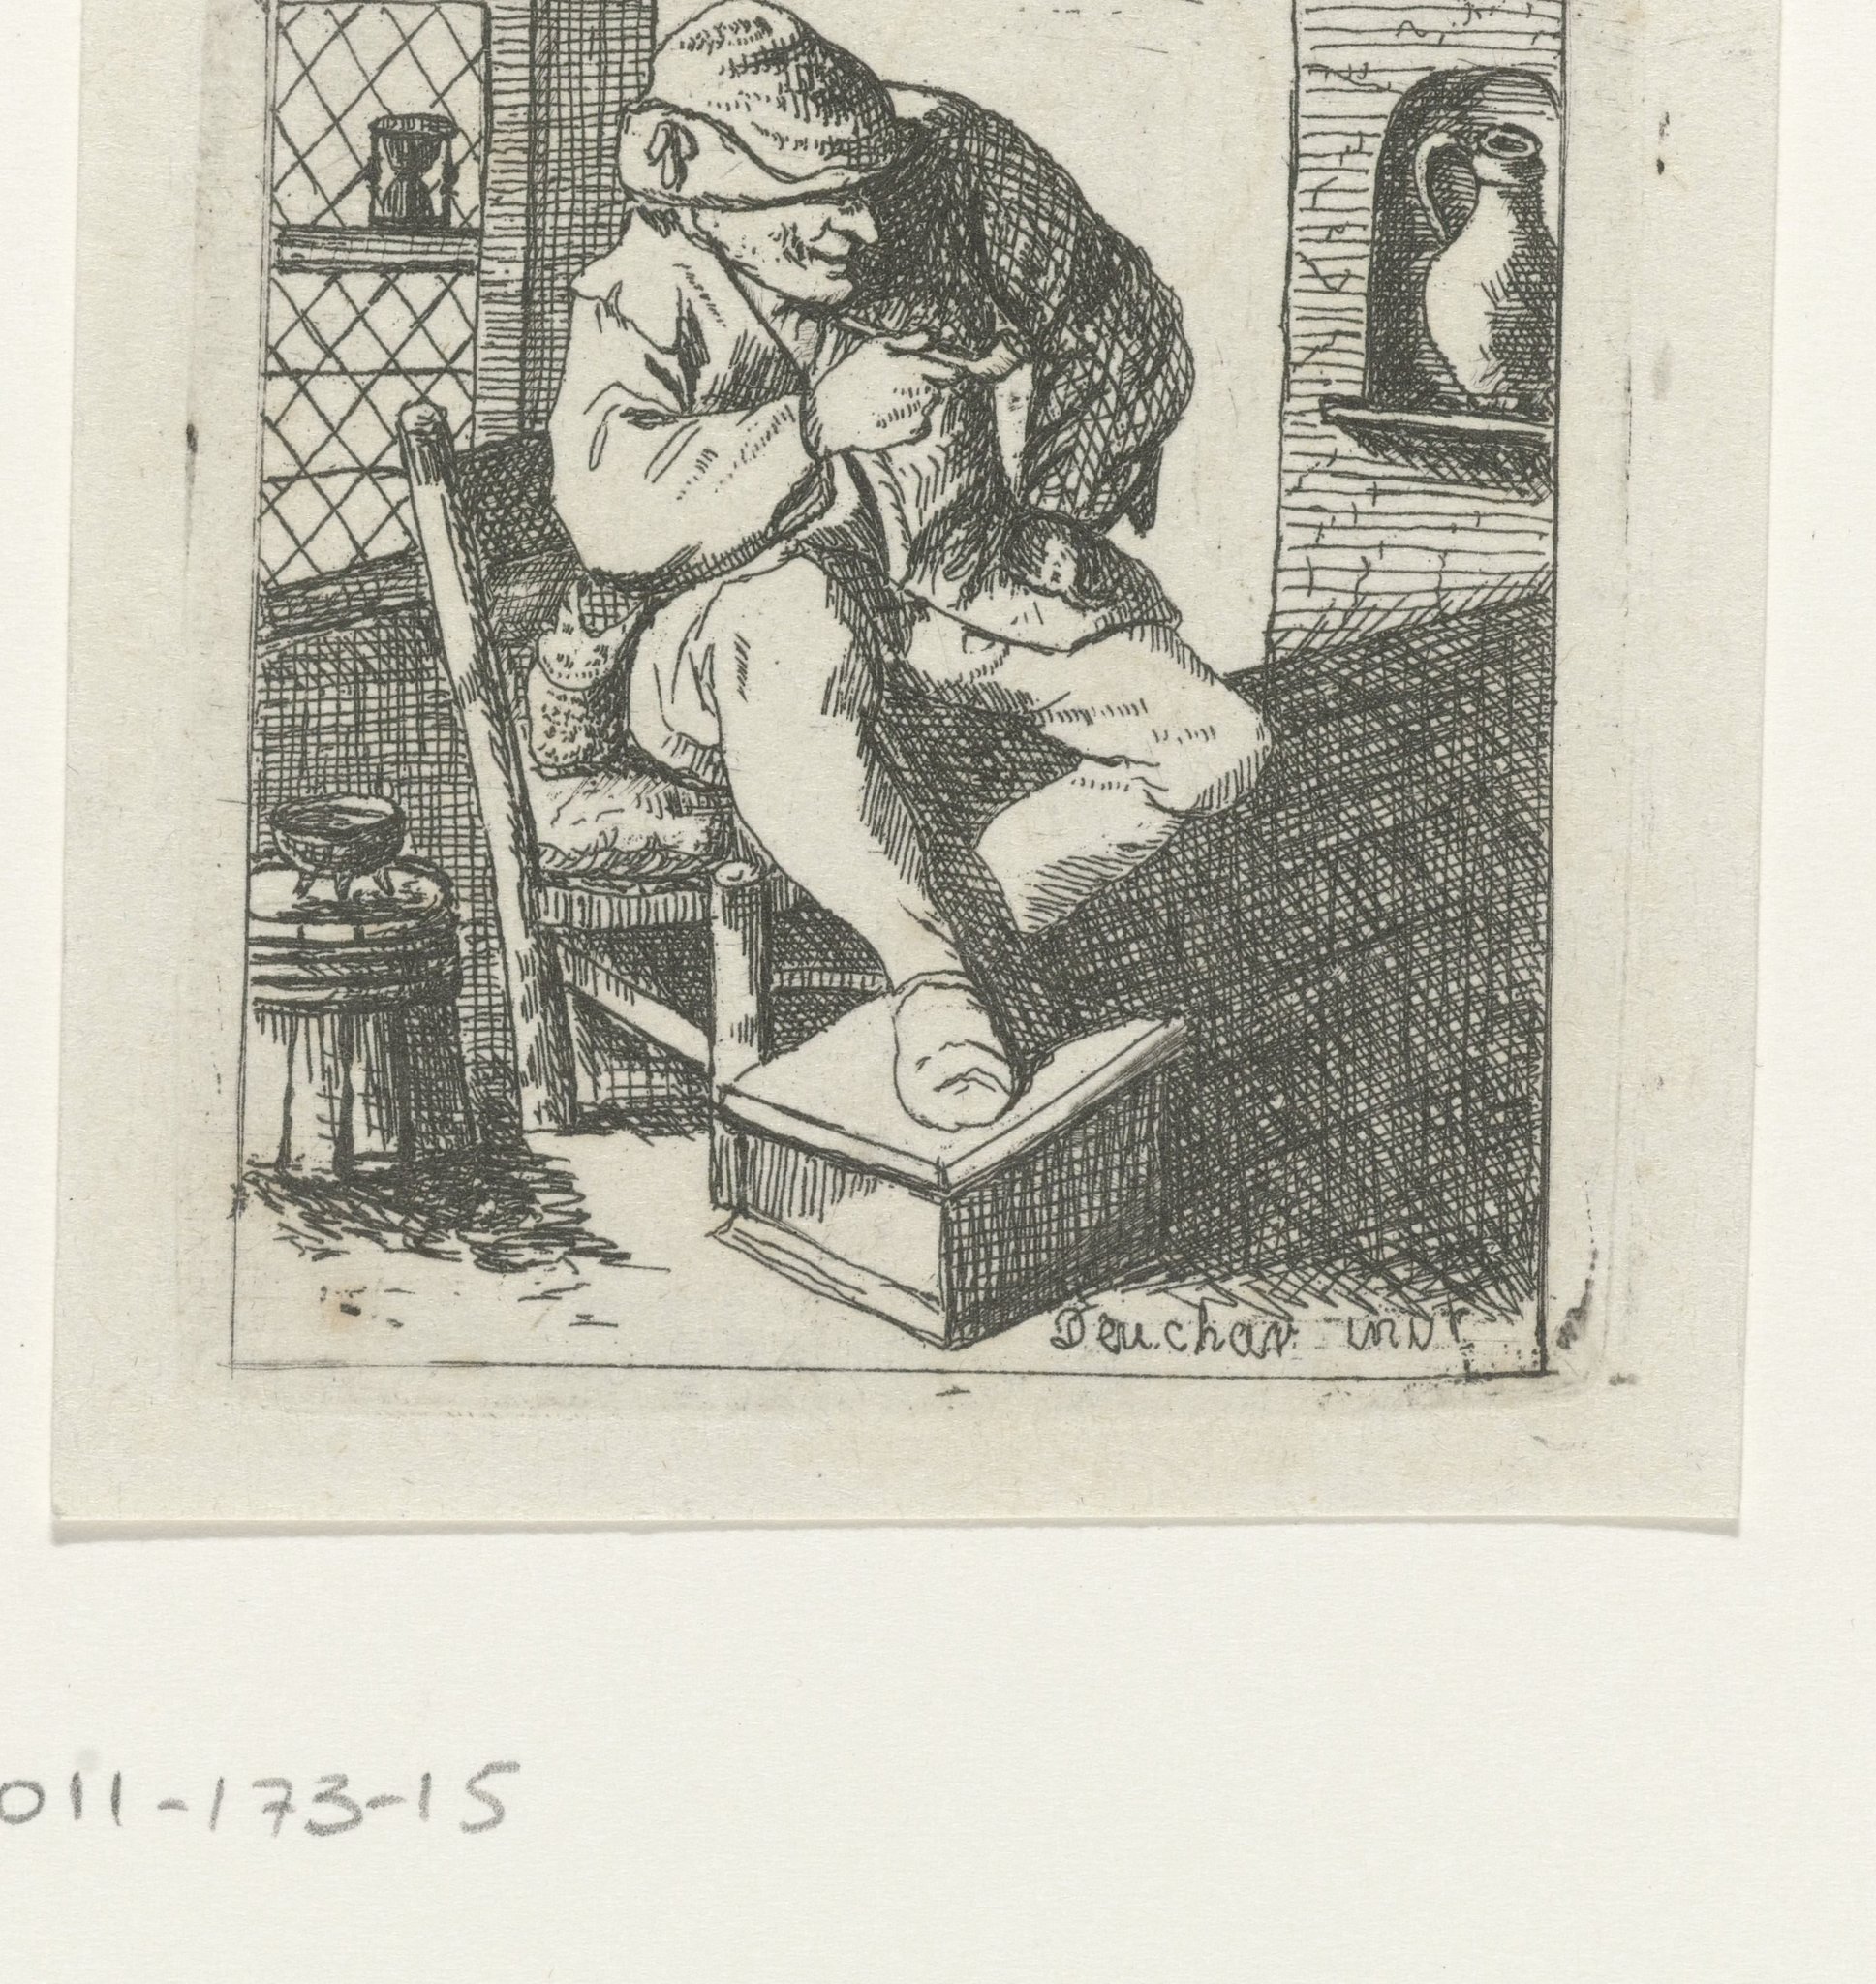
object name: print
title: Pijprokende man op stoel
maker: david deuchar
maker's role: print maker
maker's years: 1743-1808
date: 1755-1808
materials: paper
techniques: etching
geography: europe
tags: pipe ~ tobacco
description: Na de overname van de firma Niemeyer door British American Tabacco Group besloot deze de collectie van het Niemeyer Tabaksmuseum af te stoten. De beheerder van de collectie, het Noordelijk Scheepvaartmuseum, organiseerde in januari 2011 open dagen voor musea waar deze hun voorkeuren voor collectieonderdelen kenbaar konden maken. De objecten zijn getaxeerd door medewerkers van Christie's en vervolgens ter overname aangeboden aan de belangstellende musea. Het Rijksprentenkabinet koos 46 prenten uit de collectie tegen door de medewerkers van Christie's vastgestelde waarde. [H. Leeflang, 2011-06-09]